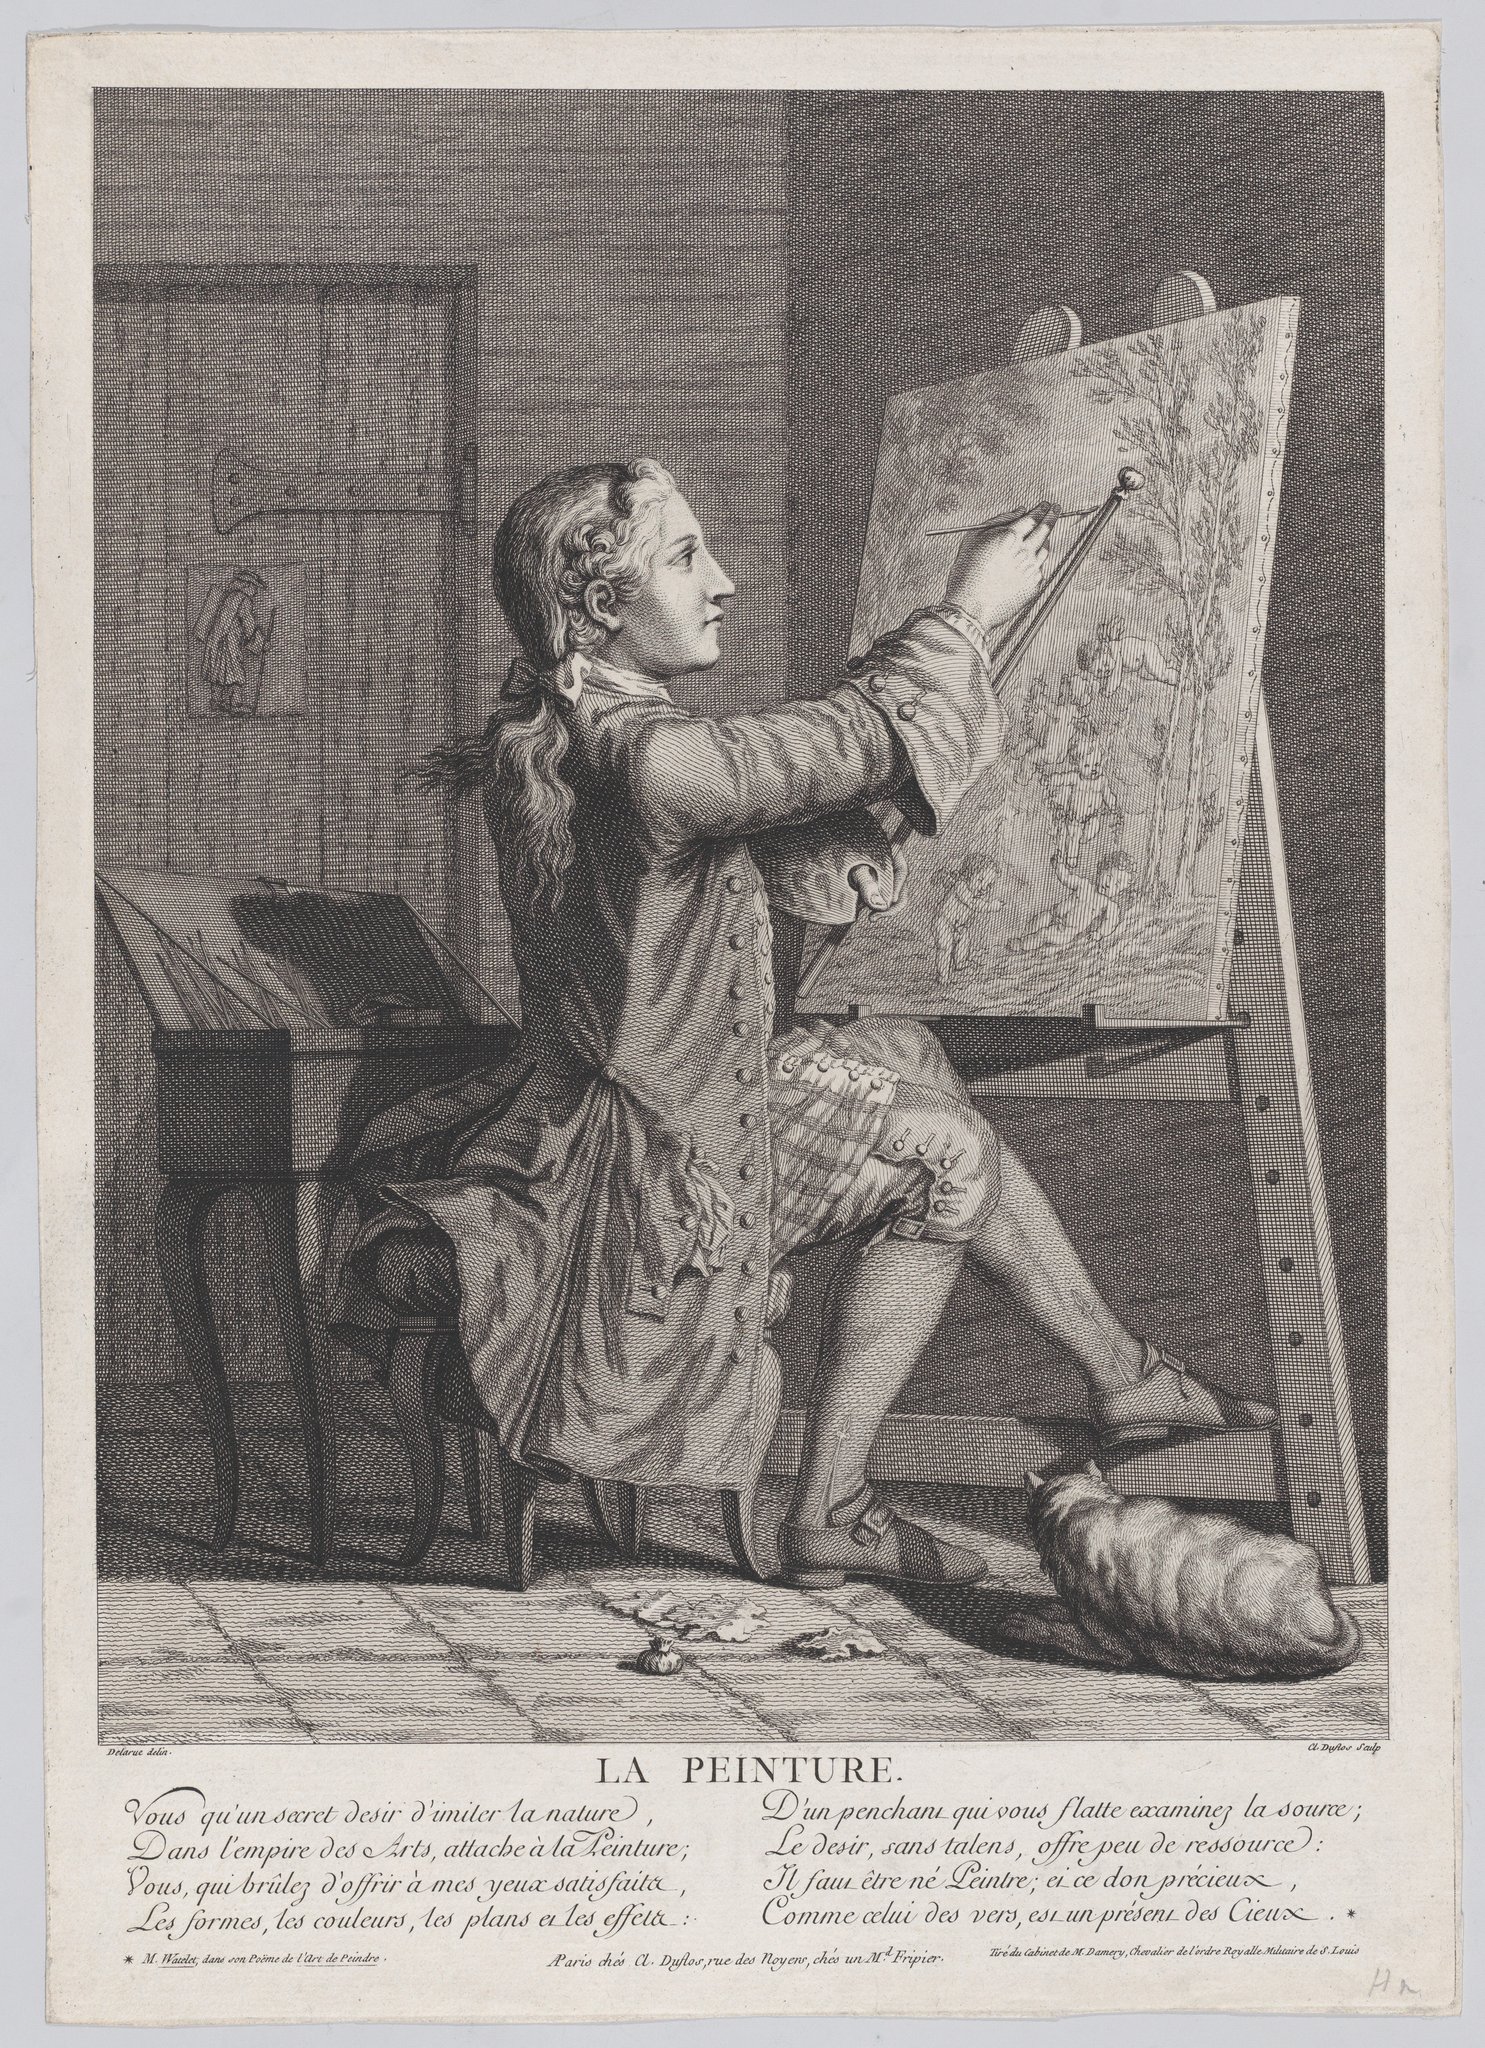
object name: print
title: La Peinture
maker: claude augustin duflos le jeune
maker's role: artist and publisher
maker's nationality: french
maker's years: 1700-1786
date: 1770-1786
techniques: engraving, etching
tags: painting,men,cats,artists